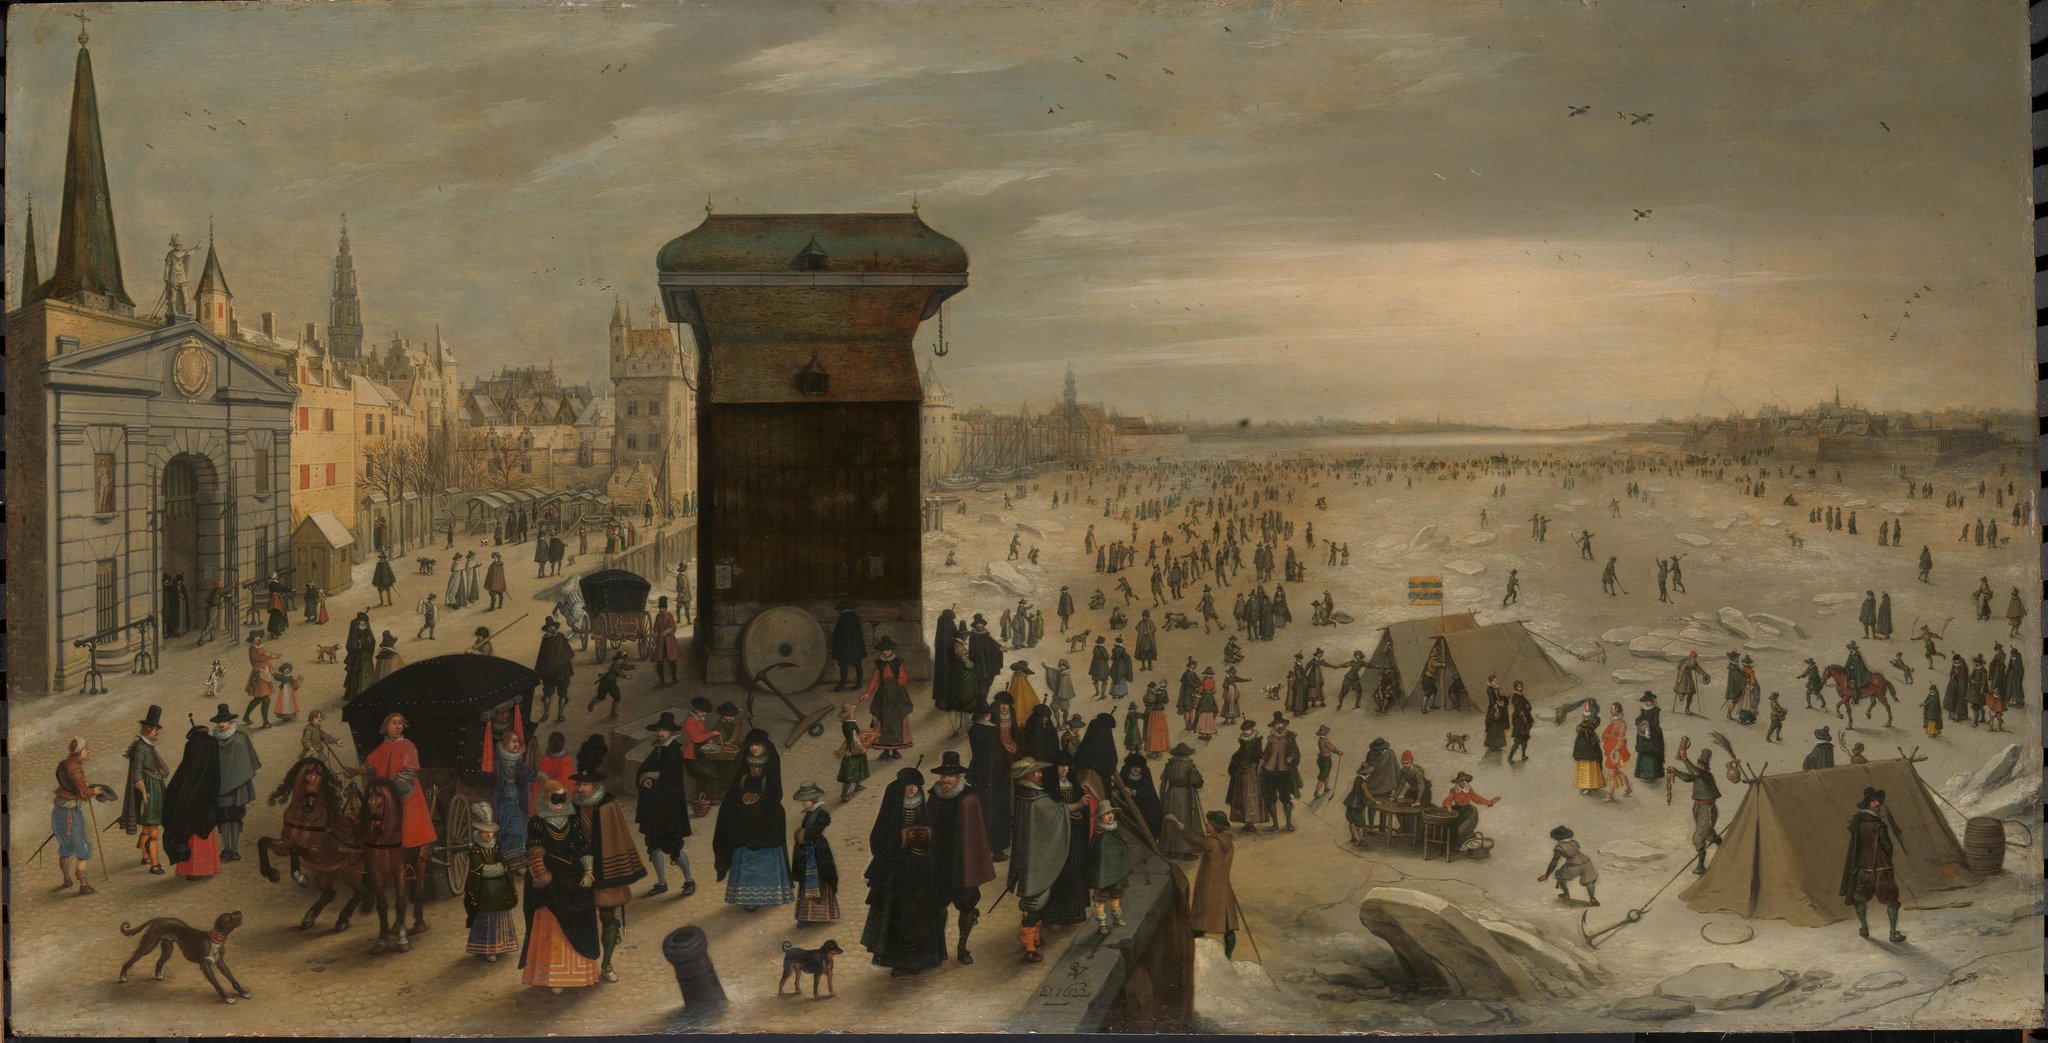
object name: painting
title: The Crane on the Antwerp Quay by the Frozen Scheldt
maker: sebastiaen vrancx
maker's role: draughtsman, painter, print maker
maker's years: 1573-1647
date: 1622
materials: oil, panel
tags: winter sports, ice ~ freezing weather, quay, antwerp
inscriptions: signature and date, bottom centre: ‘SV [in monogram]/ aº.1622’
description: Gezicht op het ijsvermaak op de bevroren Schelde bij het Kranenhoofd te Antwerpen. Op het ijs vele schaatsers en kolfspelers, aan de rand van het ijs staan enkele tenten. Over de kade lopen veel mensen.